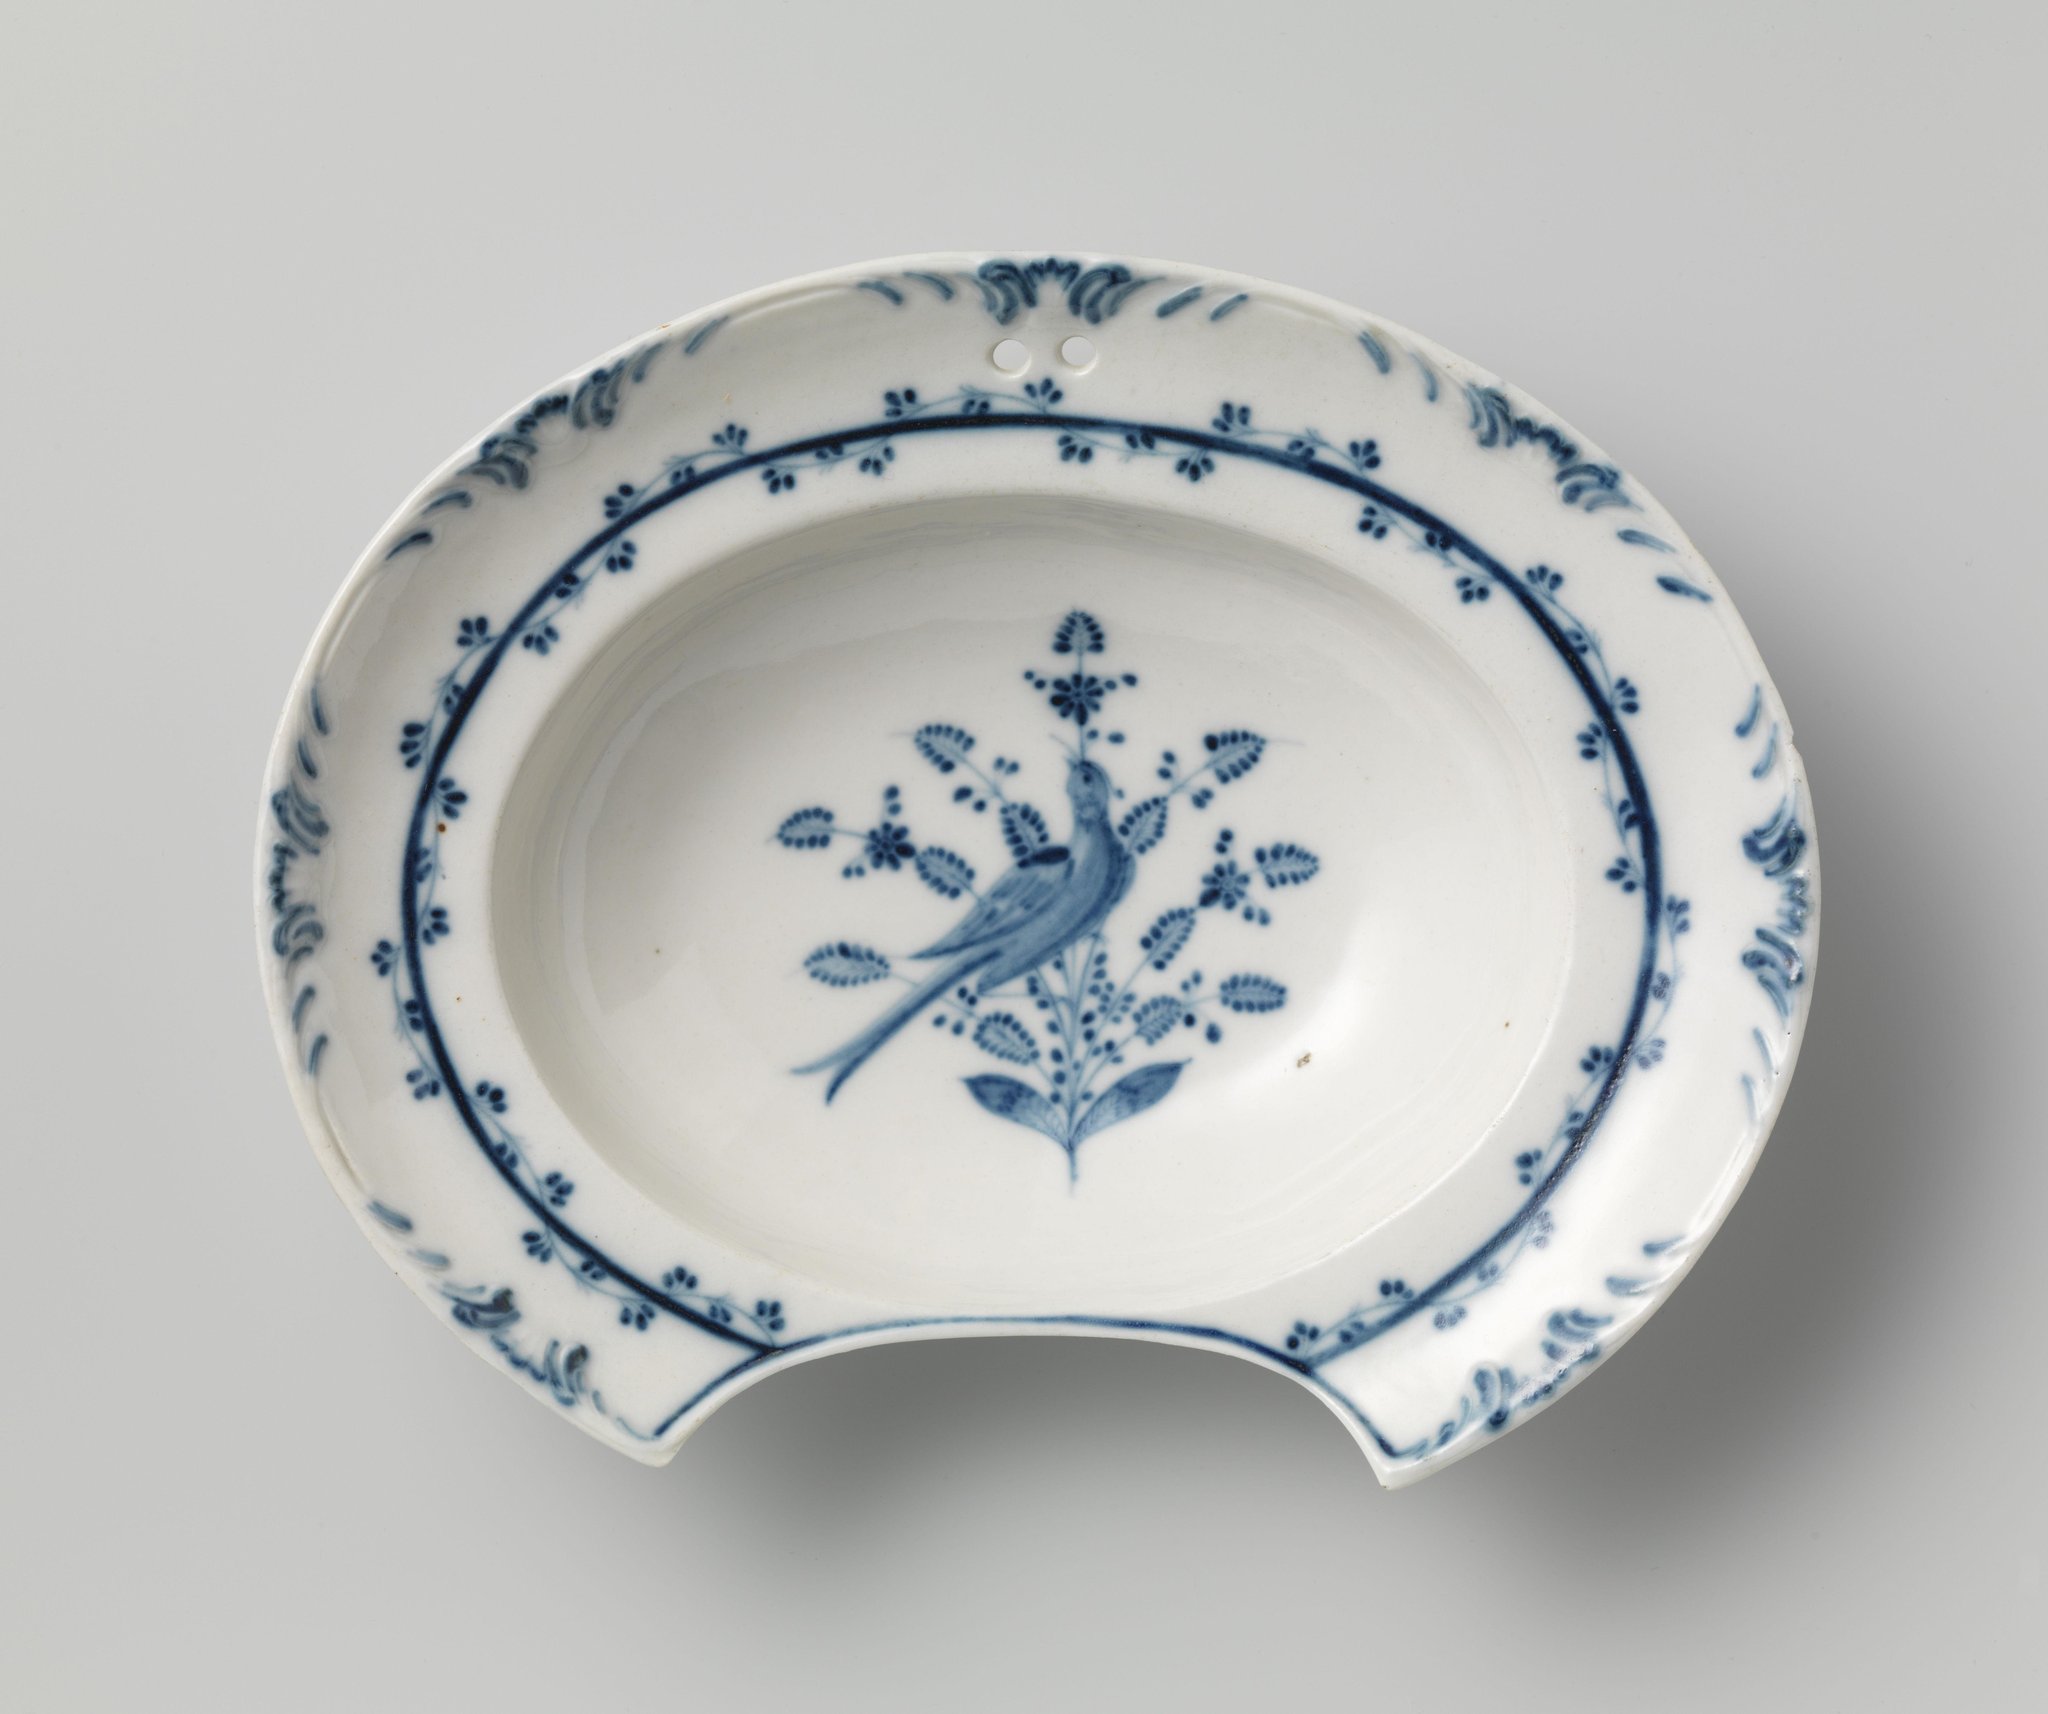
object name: shaving basin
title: Scheerbekken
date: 1778-1782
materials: porcelain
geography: loosdrecht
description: Barber's bowl. Porcelain, decorated in underglaze blue. Loosdrecht, c. 1778 - 1782. Factory of Joannes de Mol.